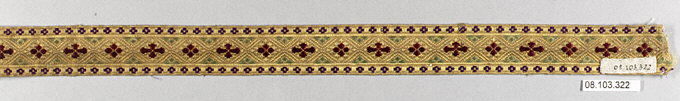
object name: galloon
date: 1801-1900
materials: silk